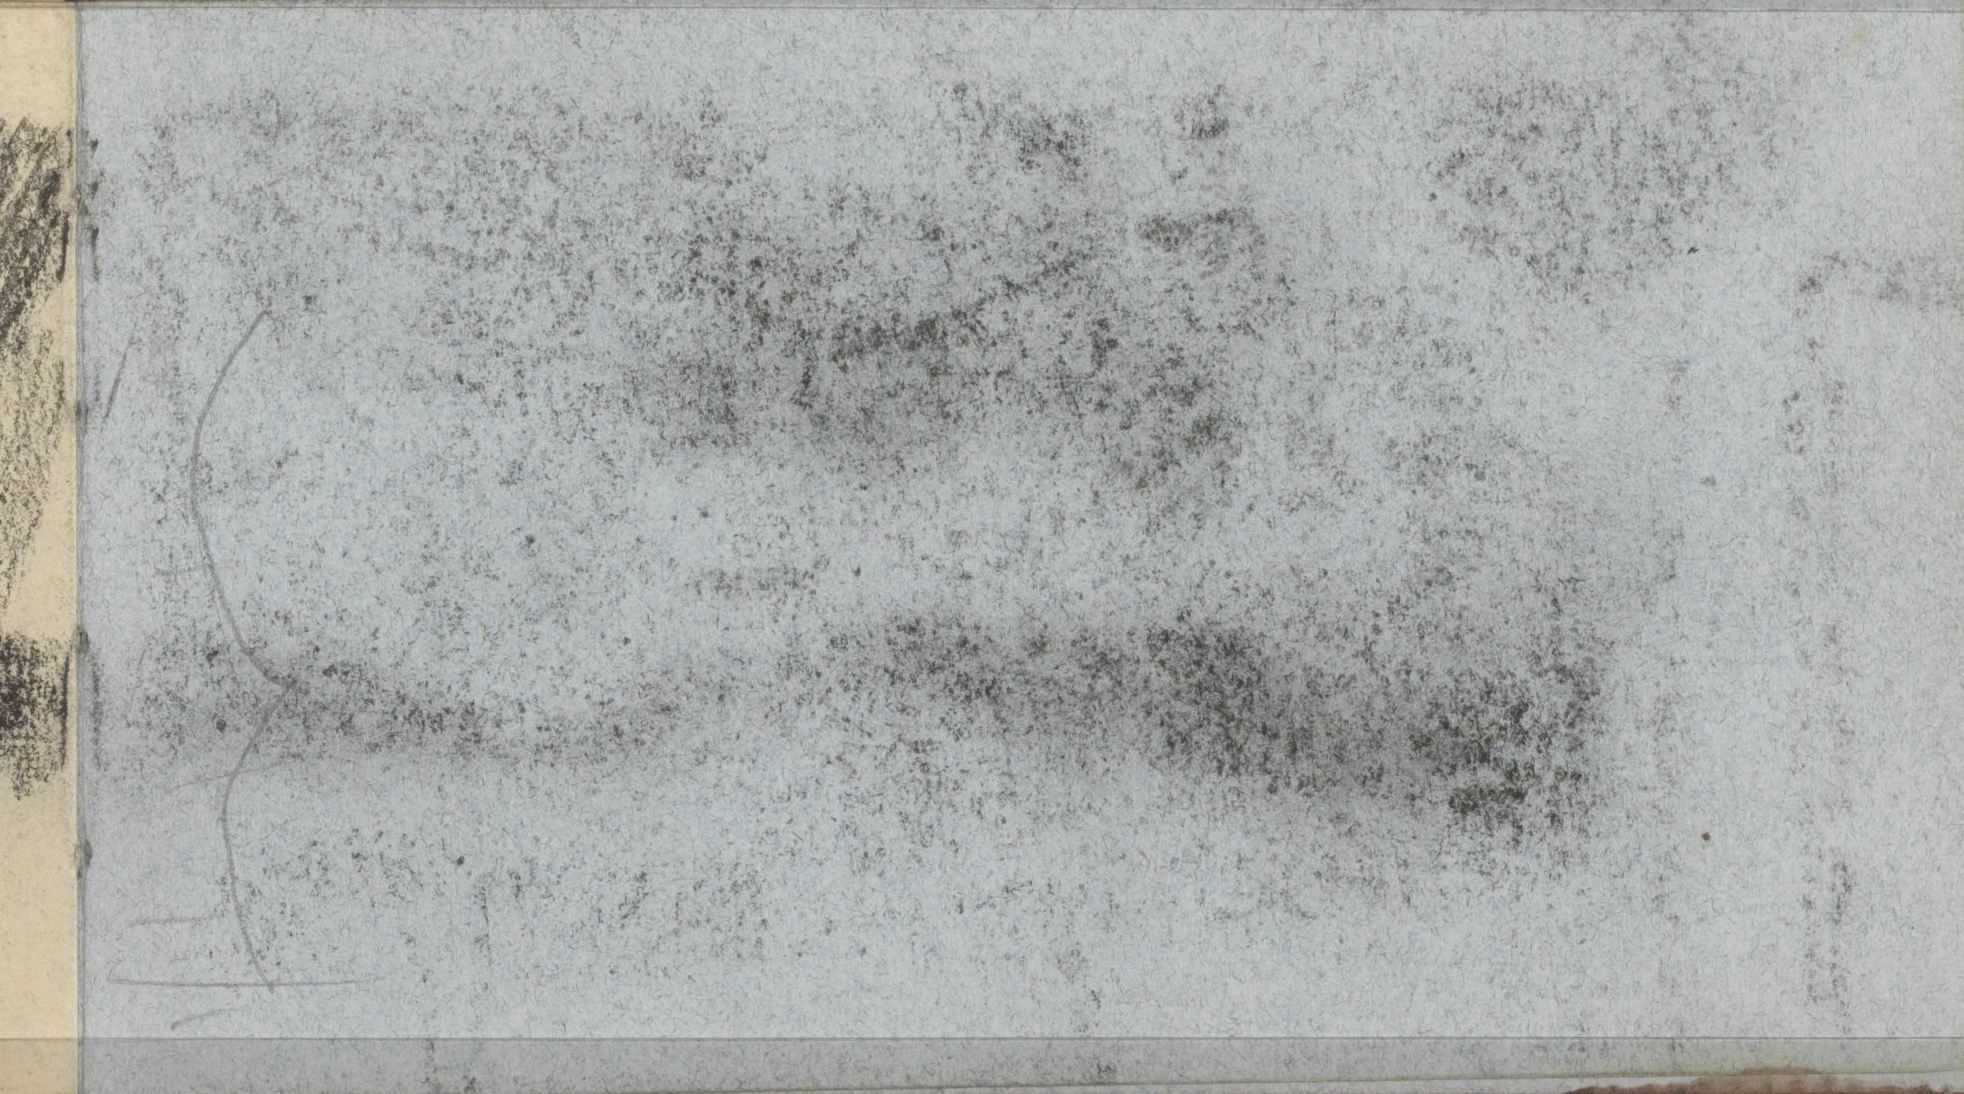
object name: sketchbook leaf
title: Studie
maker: george hendrik breitner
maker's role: draughtsman, painter, print maker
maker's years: 1857-1923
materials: paper, pencil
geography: amsterdam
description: Pagina 60 uit een schetsboek met 32 bladen.